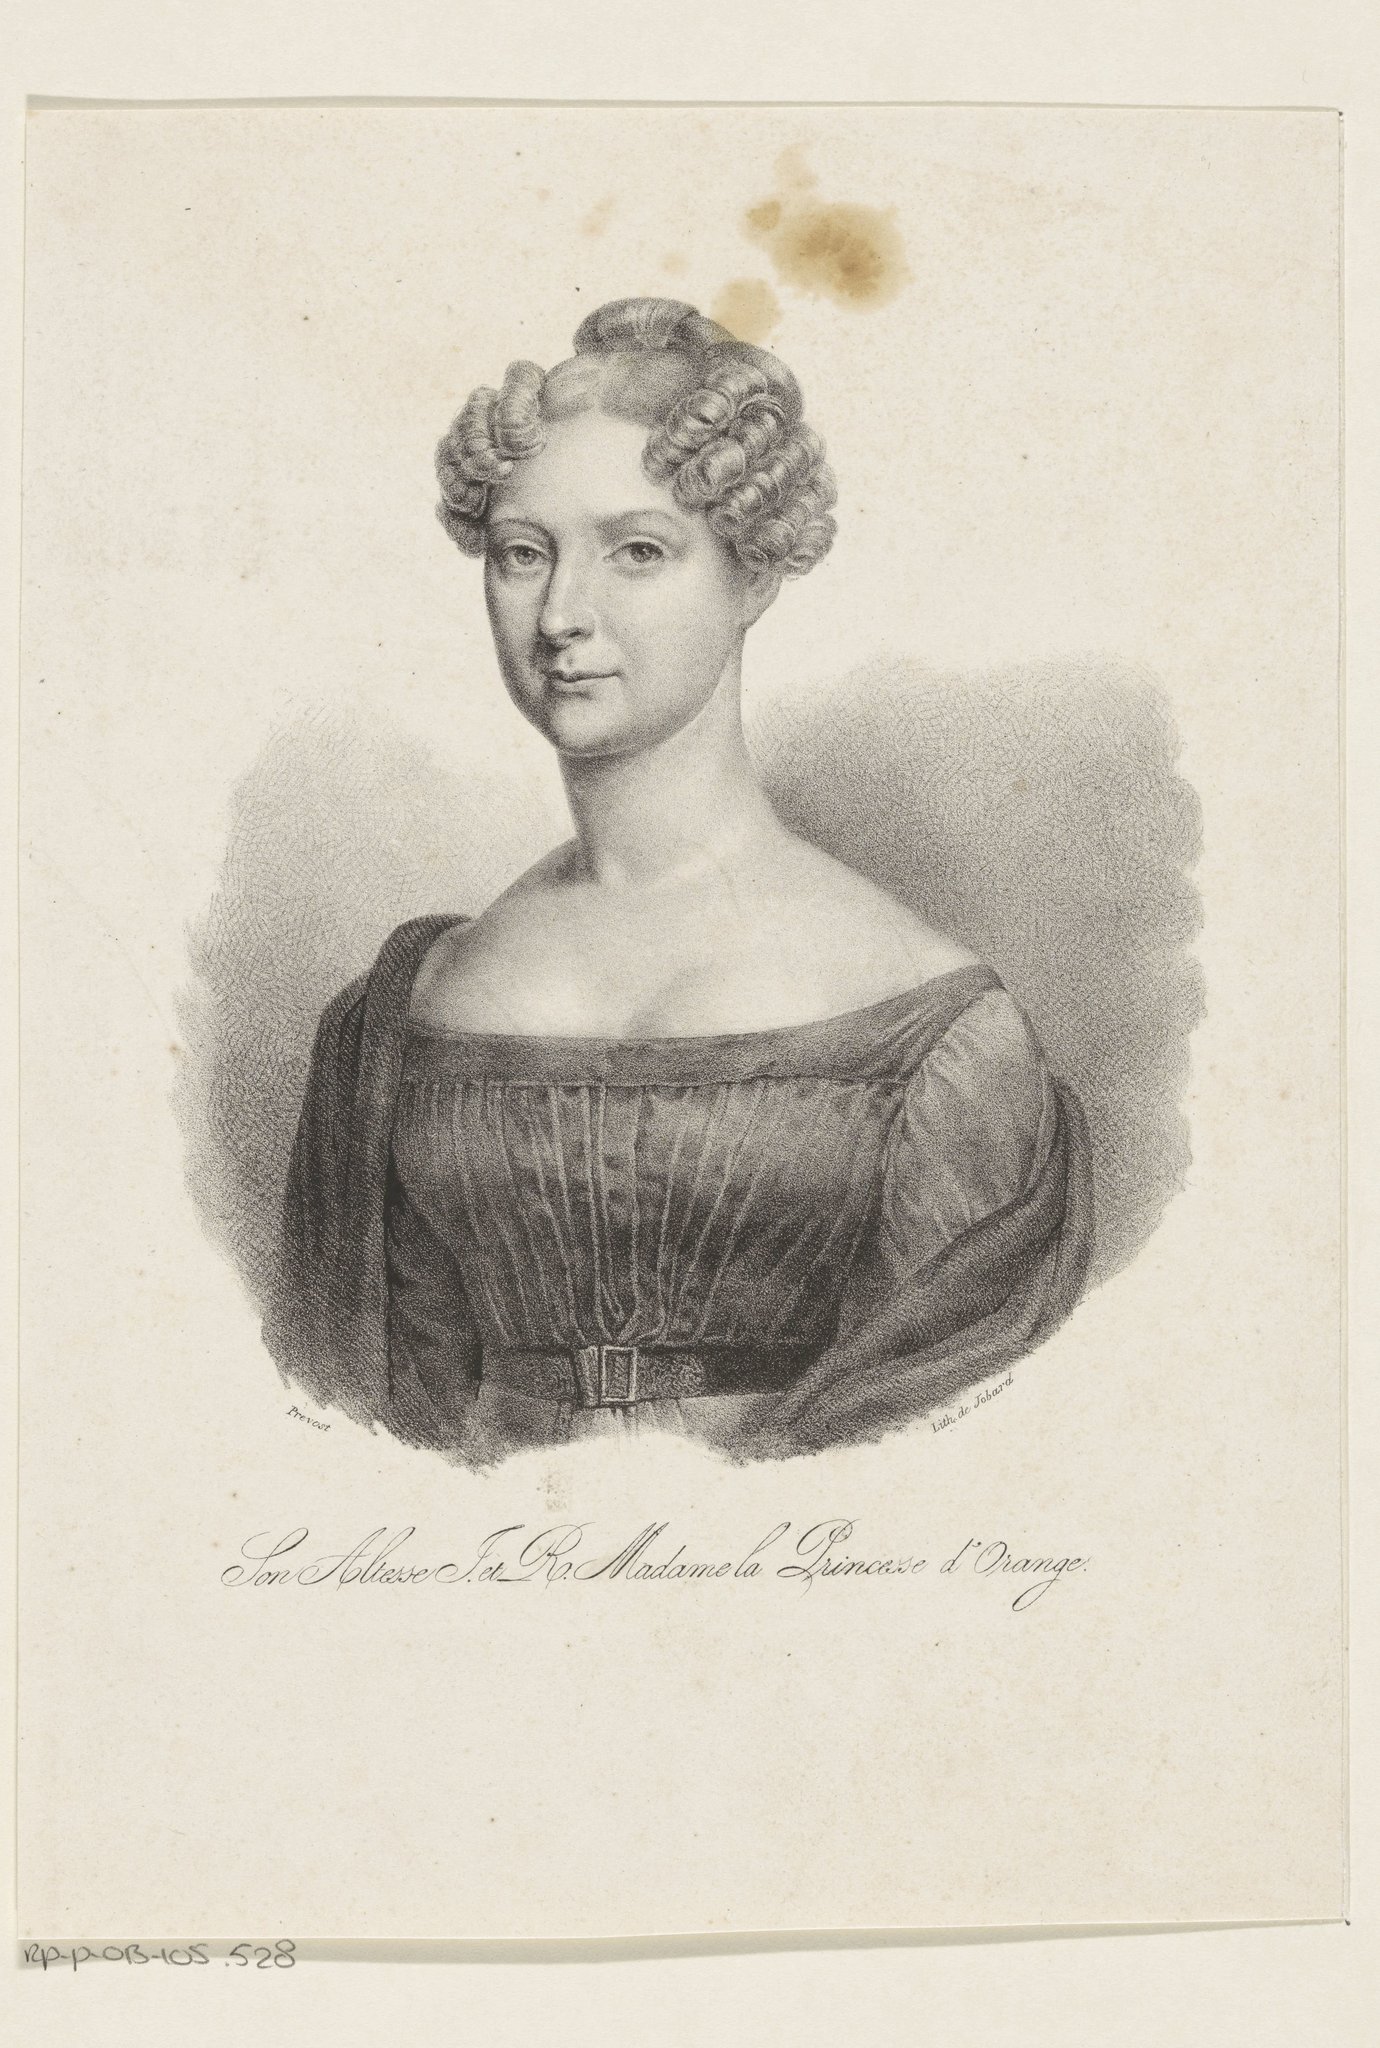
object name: print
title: Portret van Anna Paulowna Romanowa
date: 1816-1861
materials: paper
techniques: lithograph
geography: brussels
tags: anna paulowna romanowa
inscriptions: collector's mark: Lugt 2228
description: Portret van Anna Paulowna. In de ondermarge haar titel in het Frans.